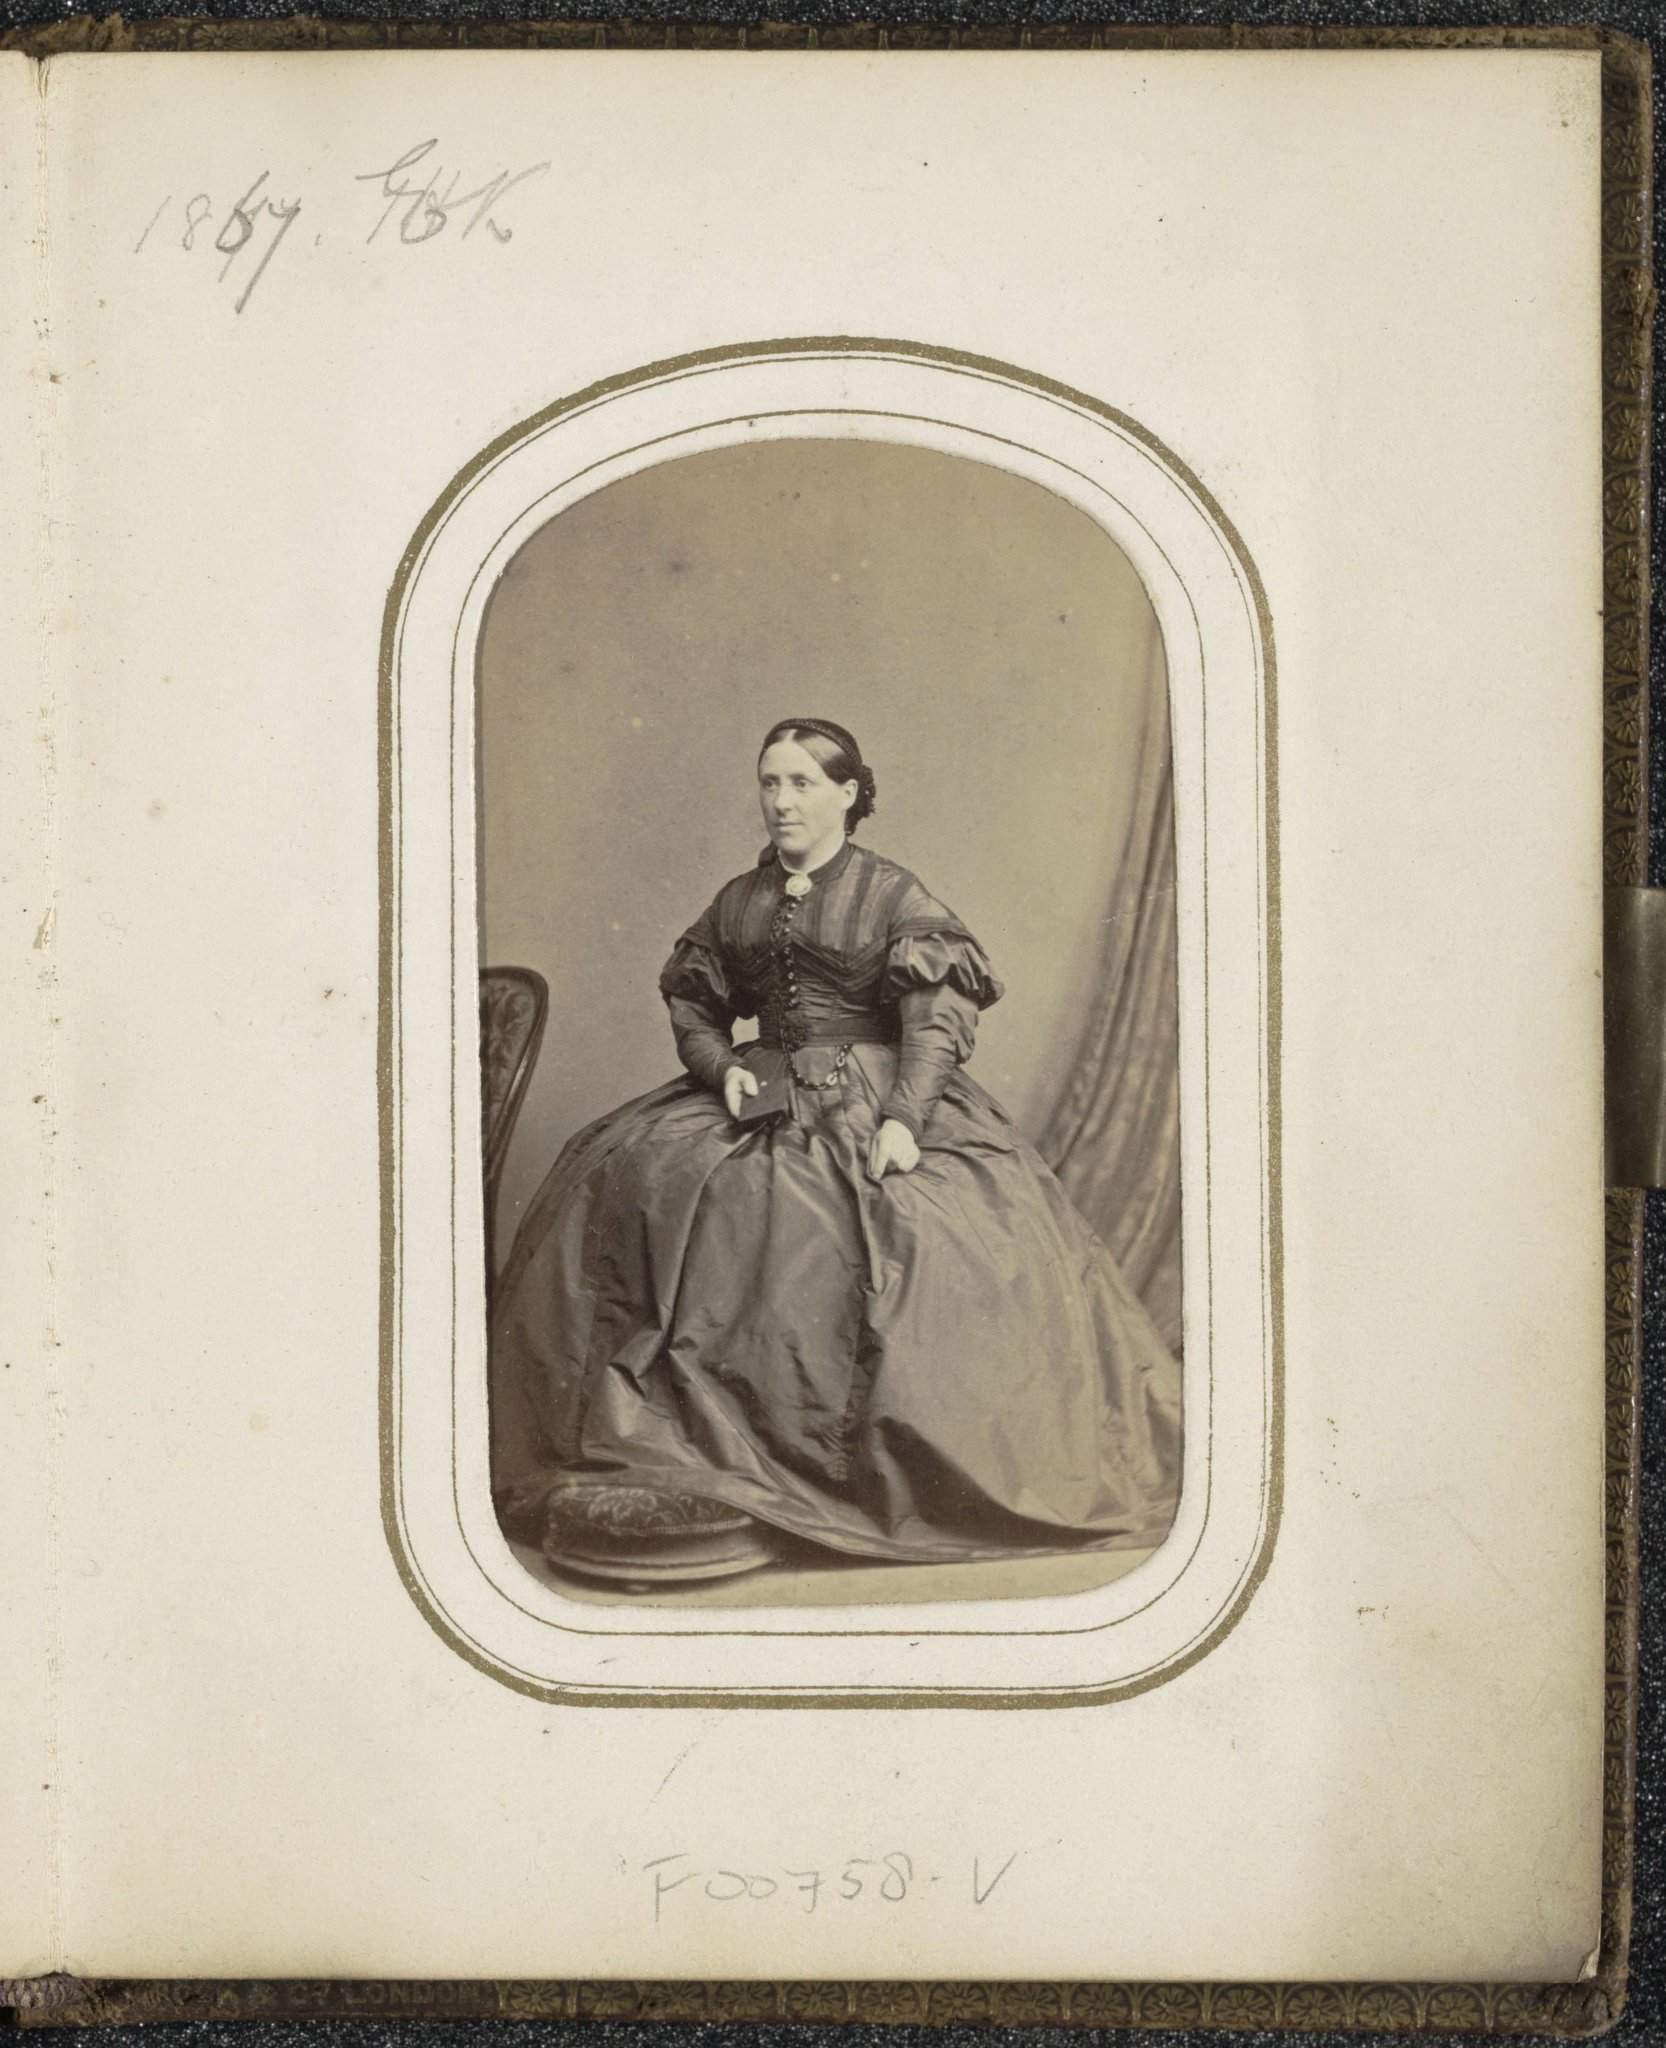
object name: carte de visite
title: Portret van een vrouw met een boek in de hand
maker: Anonymous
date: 1867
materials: cardboard, paper, photographic support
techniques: albumen print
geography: england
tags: studio requisites ~ photographer, historical persons, book, dress, gown, necklace, england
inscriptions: inscription: ‘1867 [...]K’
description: Onderdeel van Engels fotoalbum van E.A. Kettle met 42 cartes-de-visite.